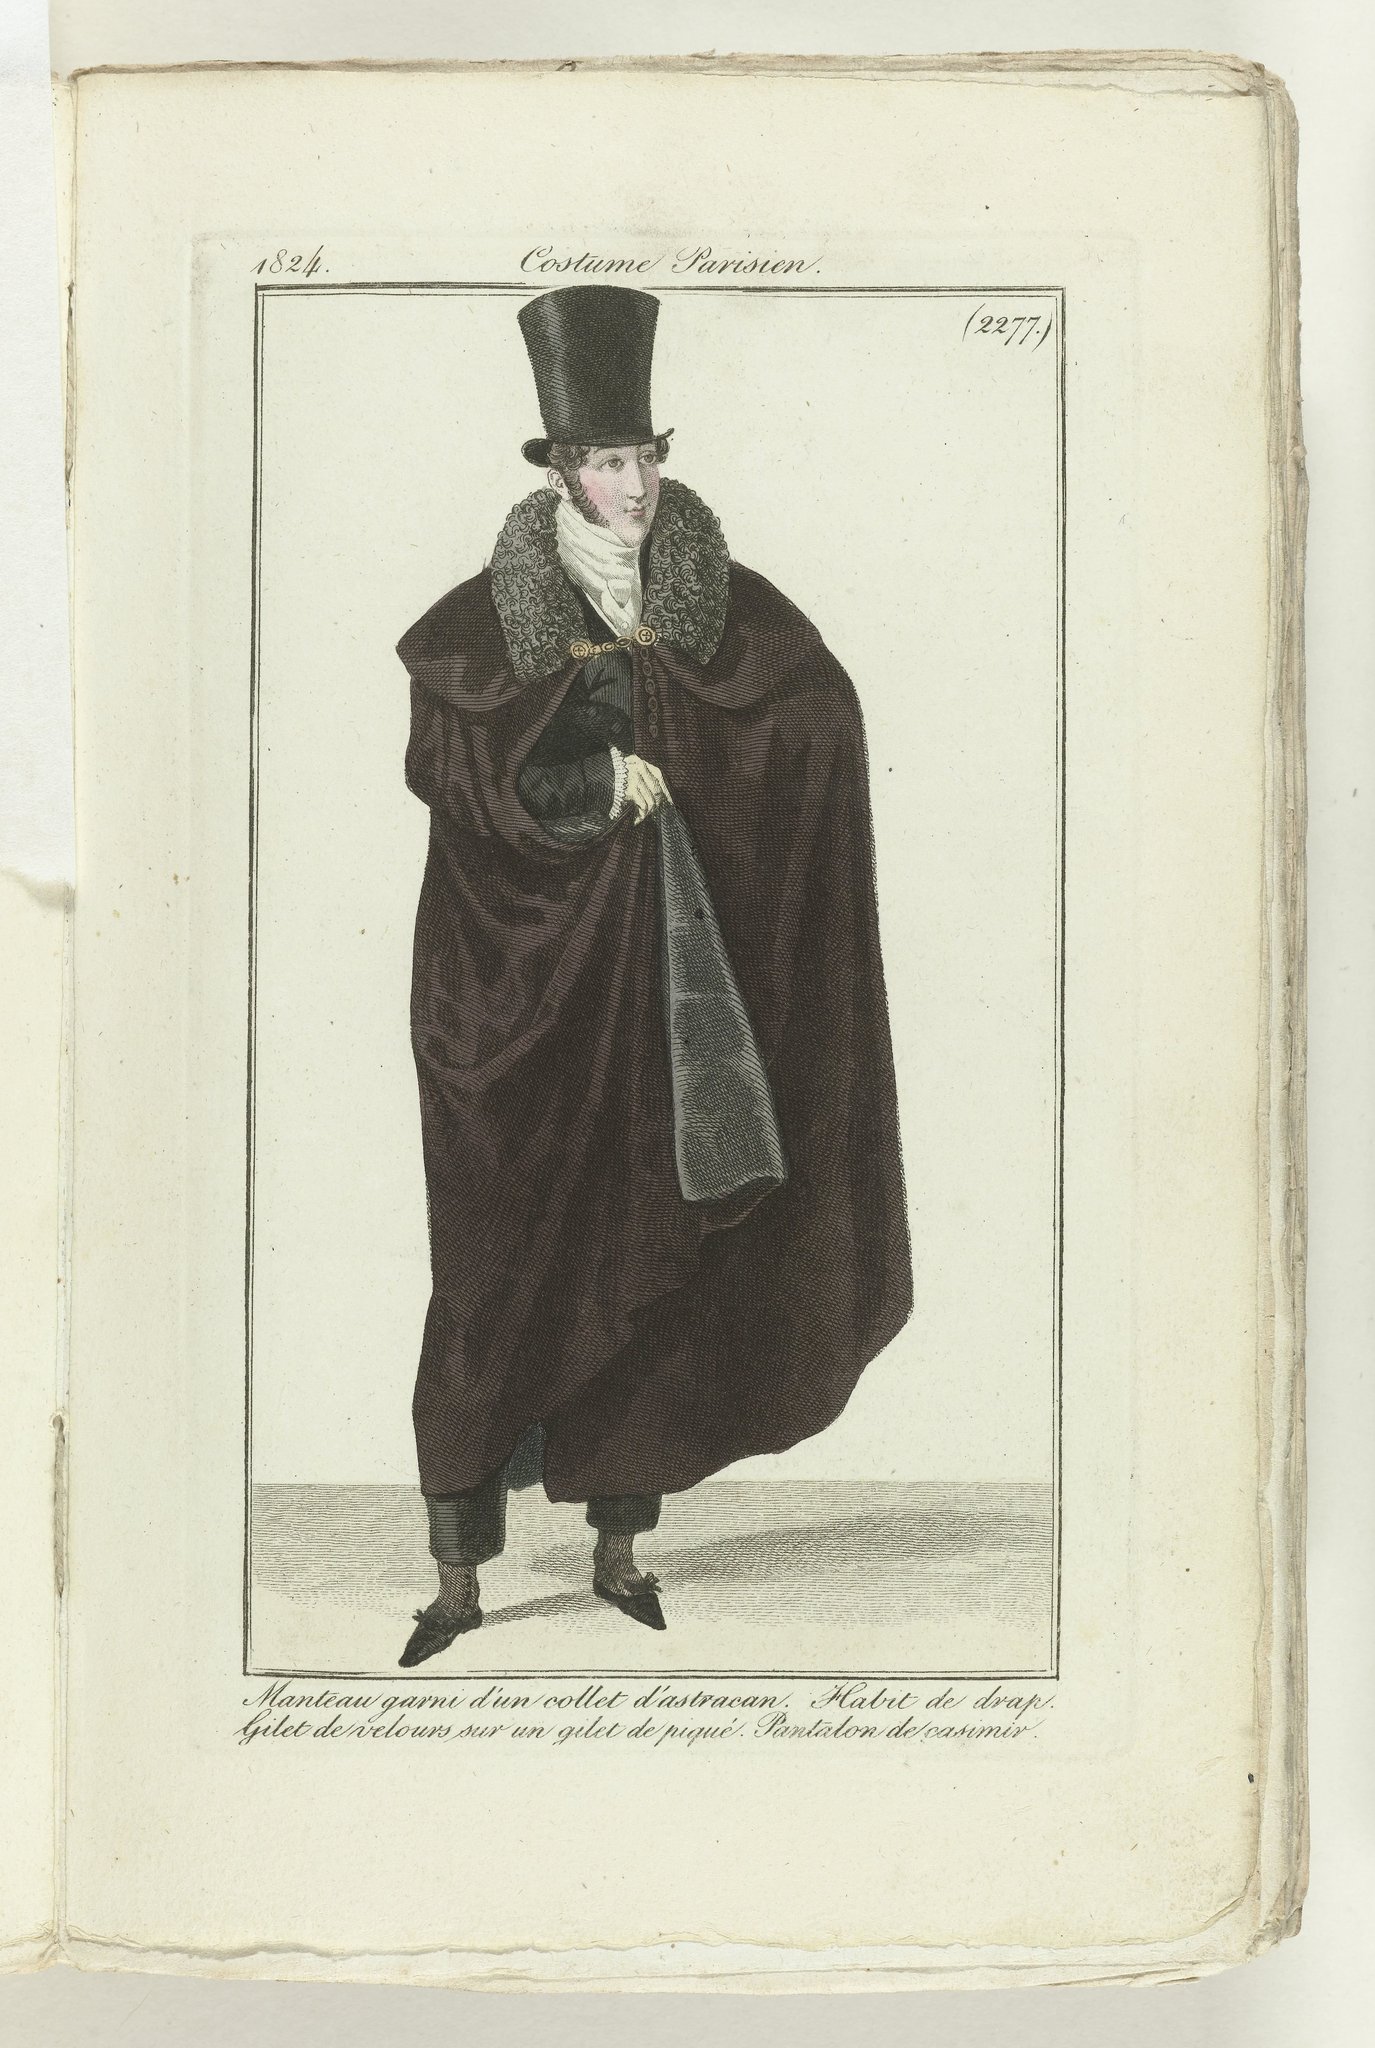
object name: fashion print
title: Journal des Dames et des Modes 1824, Costume Parisien (2277)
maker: Anonymous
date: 1824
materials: paper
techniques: etching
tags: cape (+ men's clothes), fashion plates, shoes, sandals (+ men's clothes), clothes, costume (+ men's clothes)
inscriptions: date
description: Prent uit het tijdschrift Journal des Dames et des Modes, 1824.